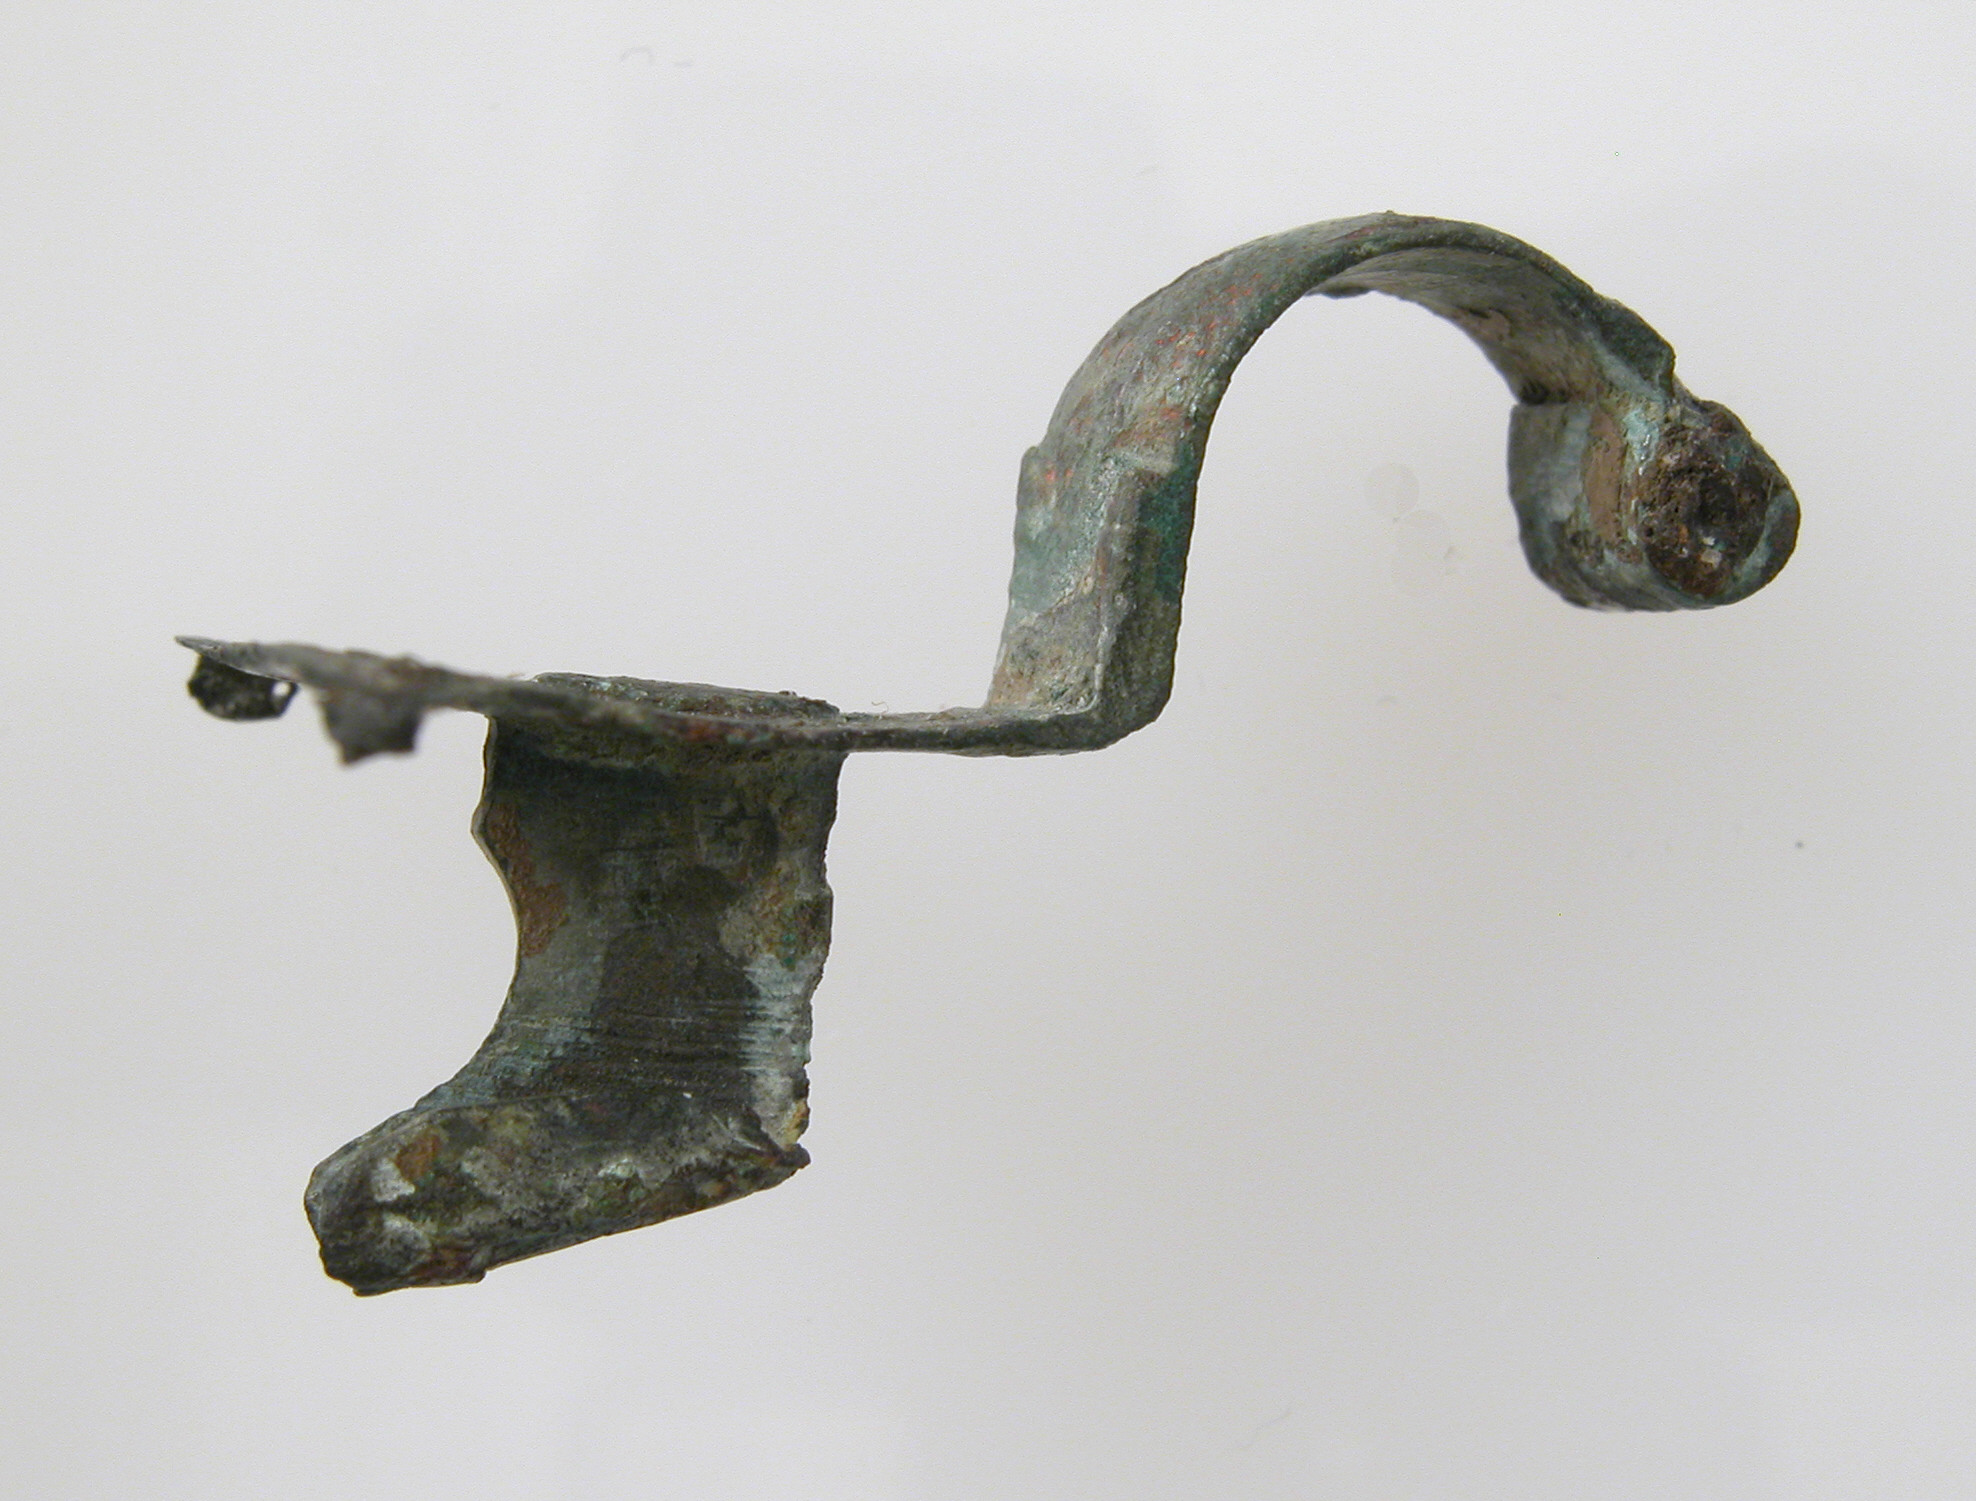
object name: pin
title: Pin Fragment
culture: roman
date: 301-400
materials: copper alloy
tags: pins